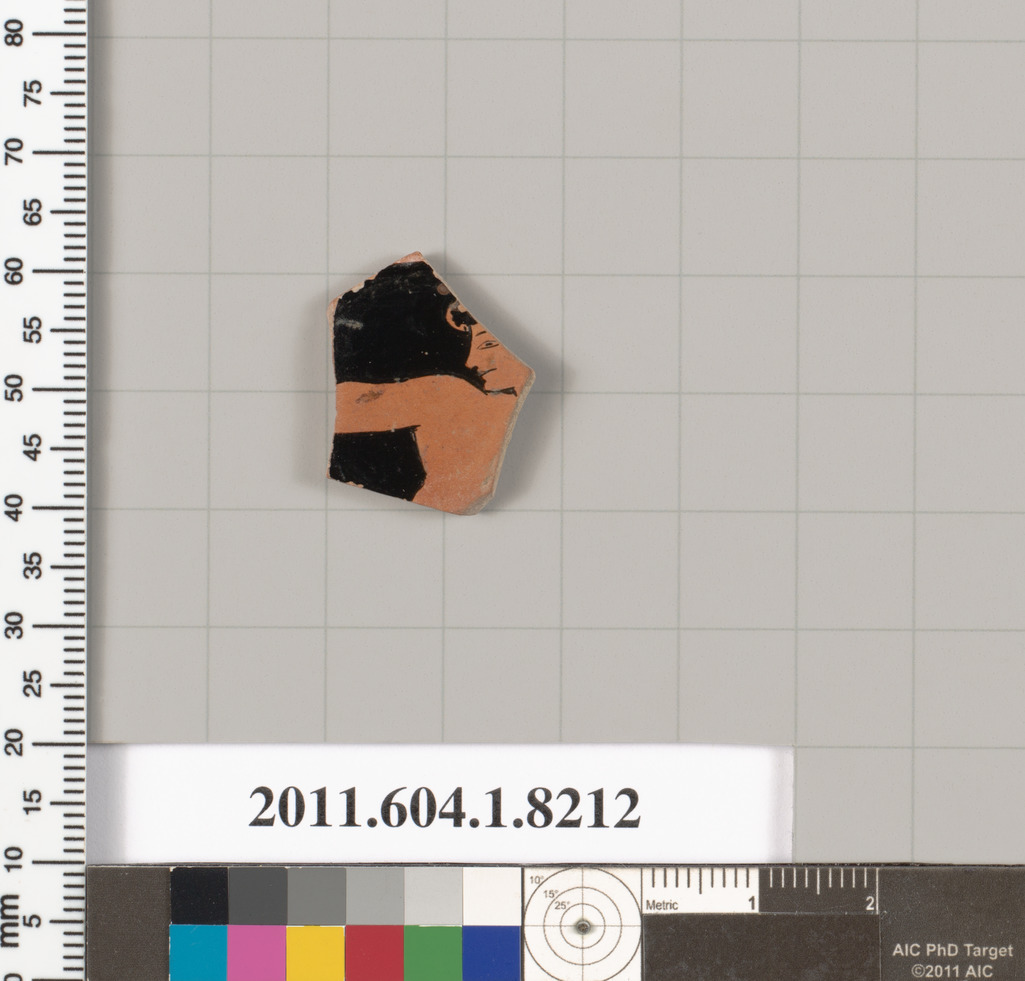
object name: kylix fragment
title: Terracotta fragment of a kylix (drinking cup)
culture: greek, attic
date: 520-510 BCE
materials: terracotta